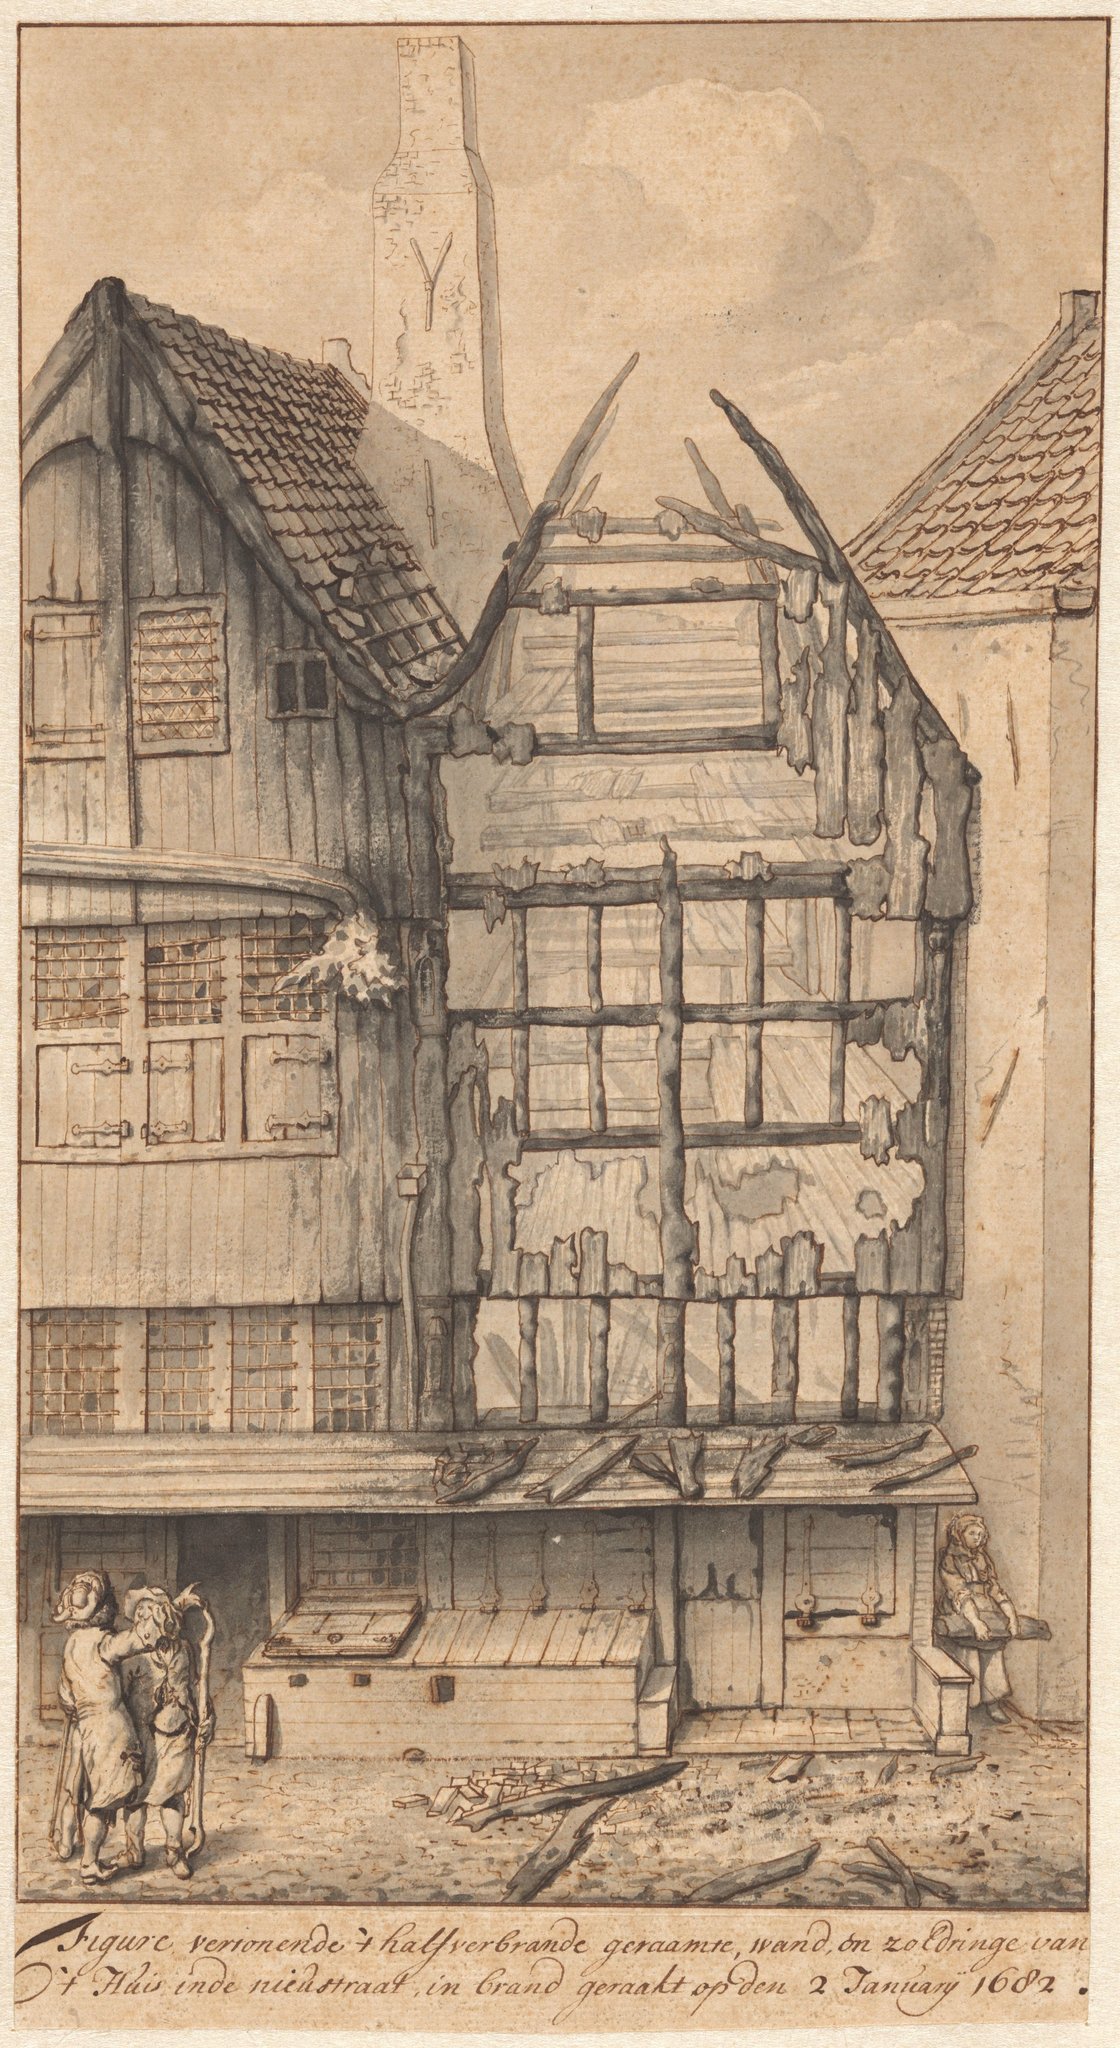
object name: design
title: Twee uitgebrande huizen in de Oude Nieuwstraat, 1682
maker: jan van der heyden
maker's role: draughtsman, painter, print maker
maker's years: 1637-1712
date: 1682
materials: chalk, ink, paper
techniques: brush, pen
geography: amsterdam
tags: amsterdam, painter, print maker, draughtsman, jan van der heyden, urban housing, ruin of a building ~ architecture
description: Ontwerptekening voor illustratie in: Heyden, Jan van der. Beschryving der nieuwlyks uitgevonden en geoctrojeerde slang-brand-spuiten en haare wyze van brand-blussen, tegenwoordig binnen Amsterdam in gebruik zijnde (…). 1e druk. Amsterdam: Jan Rieuwertsz. (II), 1690. En: Heyden, Jan van der. Beschryving der nieuwlyks uitgevonden en geoctrojeerde slang-brand-spuiten en haare wyze van brand-blussen, tegenwoordig binnen Amsterdam in gebruik zijnde (…). 2e druk. Amsterdam: erfgenamen Jan van der Heyden, 1735. Voor de prent zie RP-P-OB-82.088.